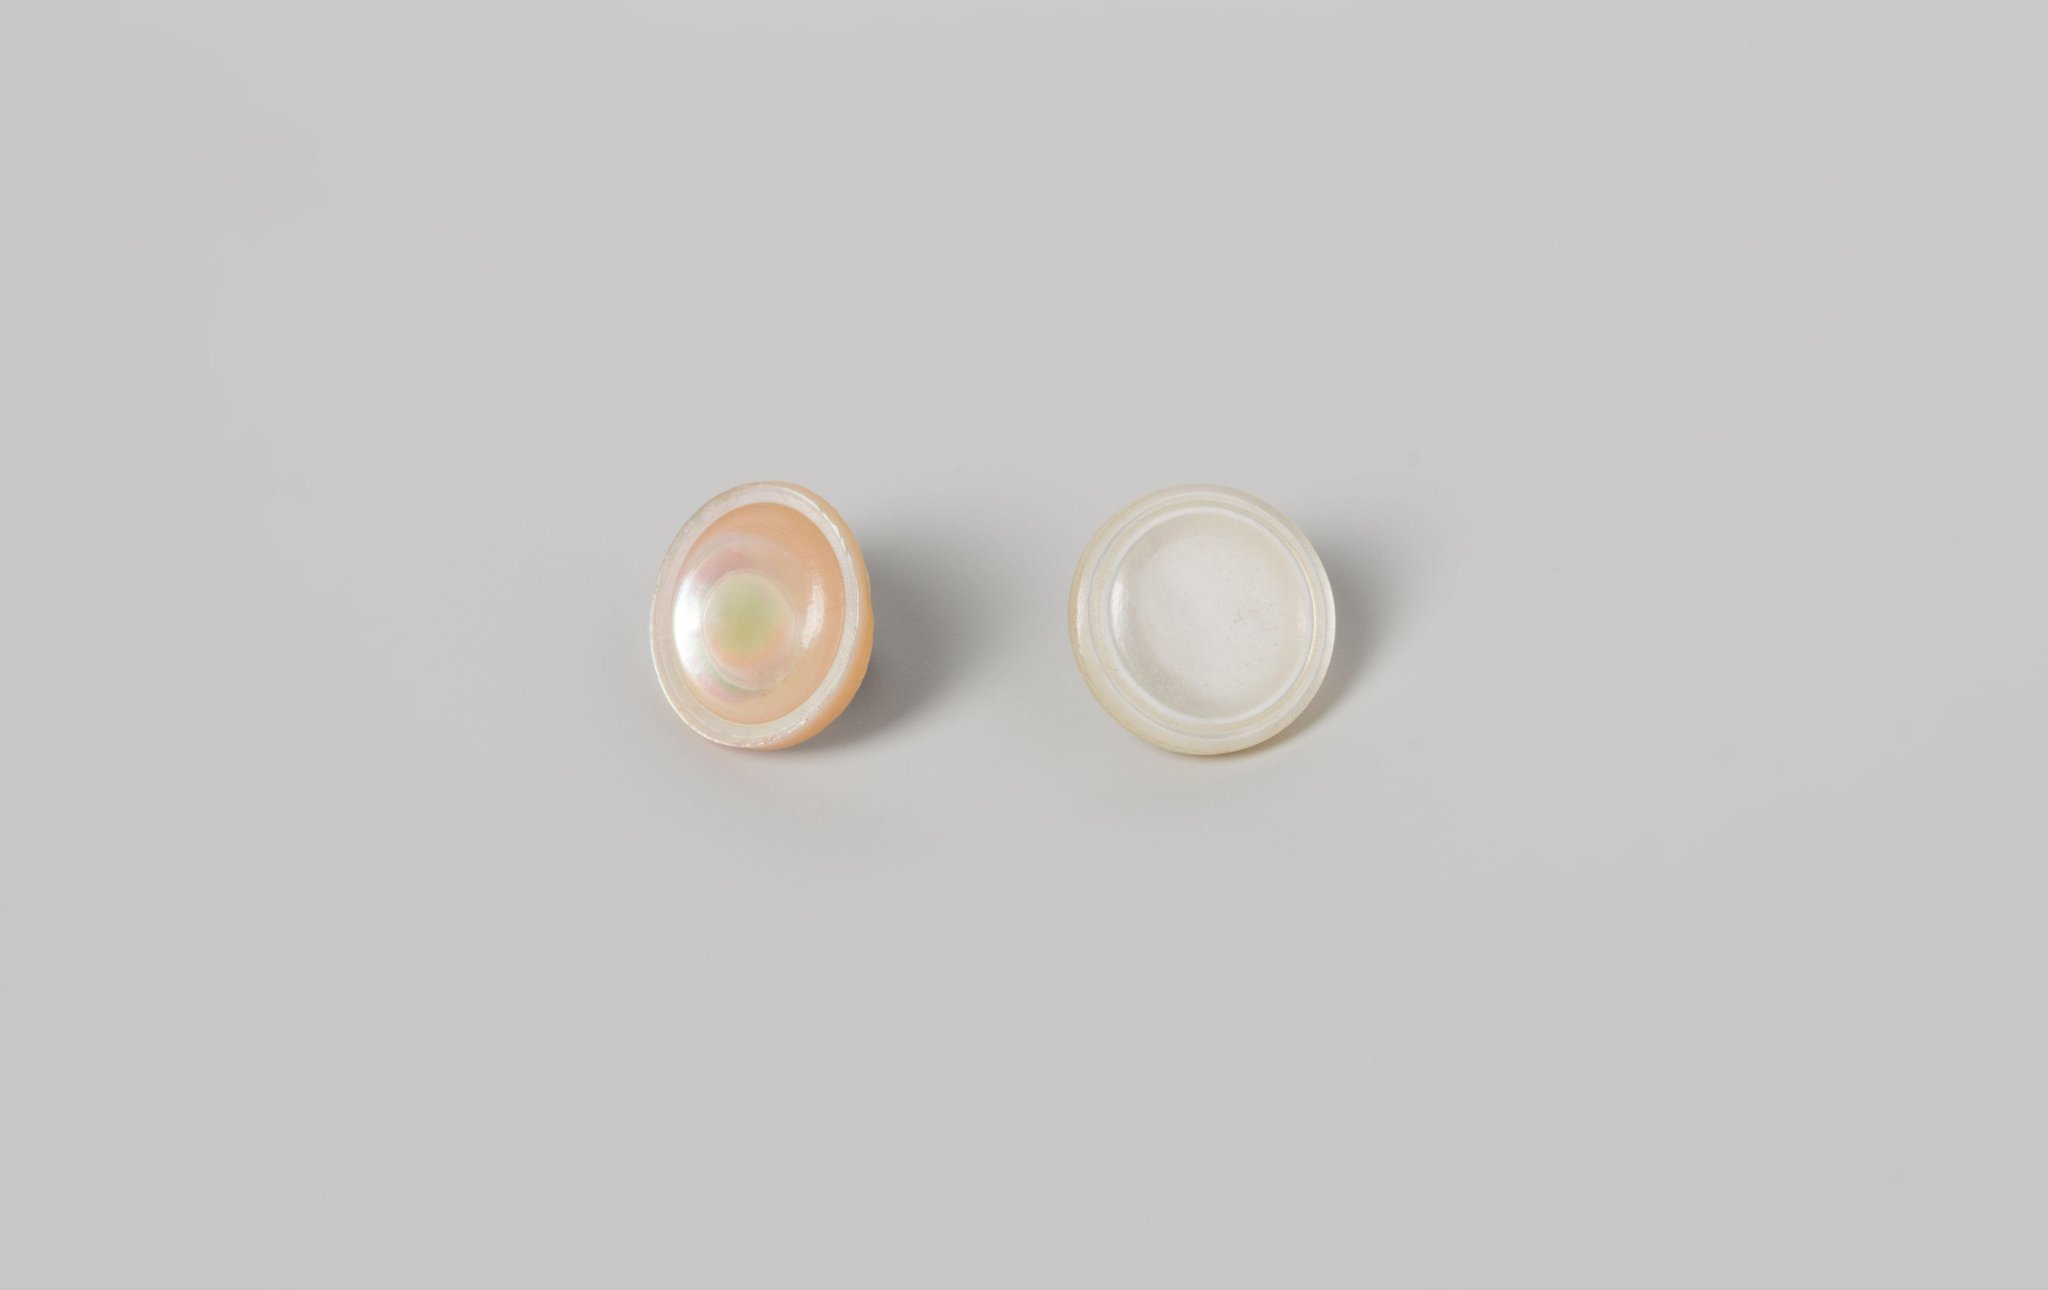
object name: menswear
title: Vestknoop van koper met parelmoer met vast oogje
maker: Anonymous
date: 1900-1940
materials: copper, mother of pearl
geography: netherlands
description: Vestknoop van koper met parelmoer met vast oogje.